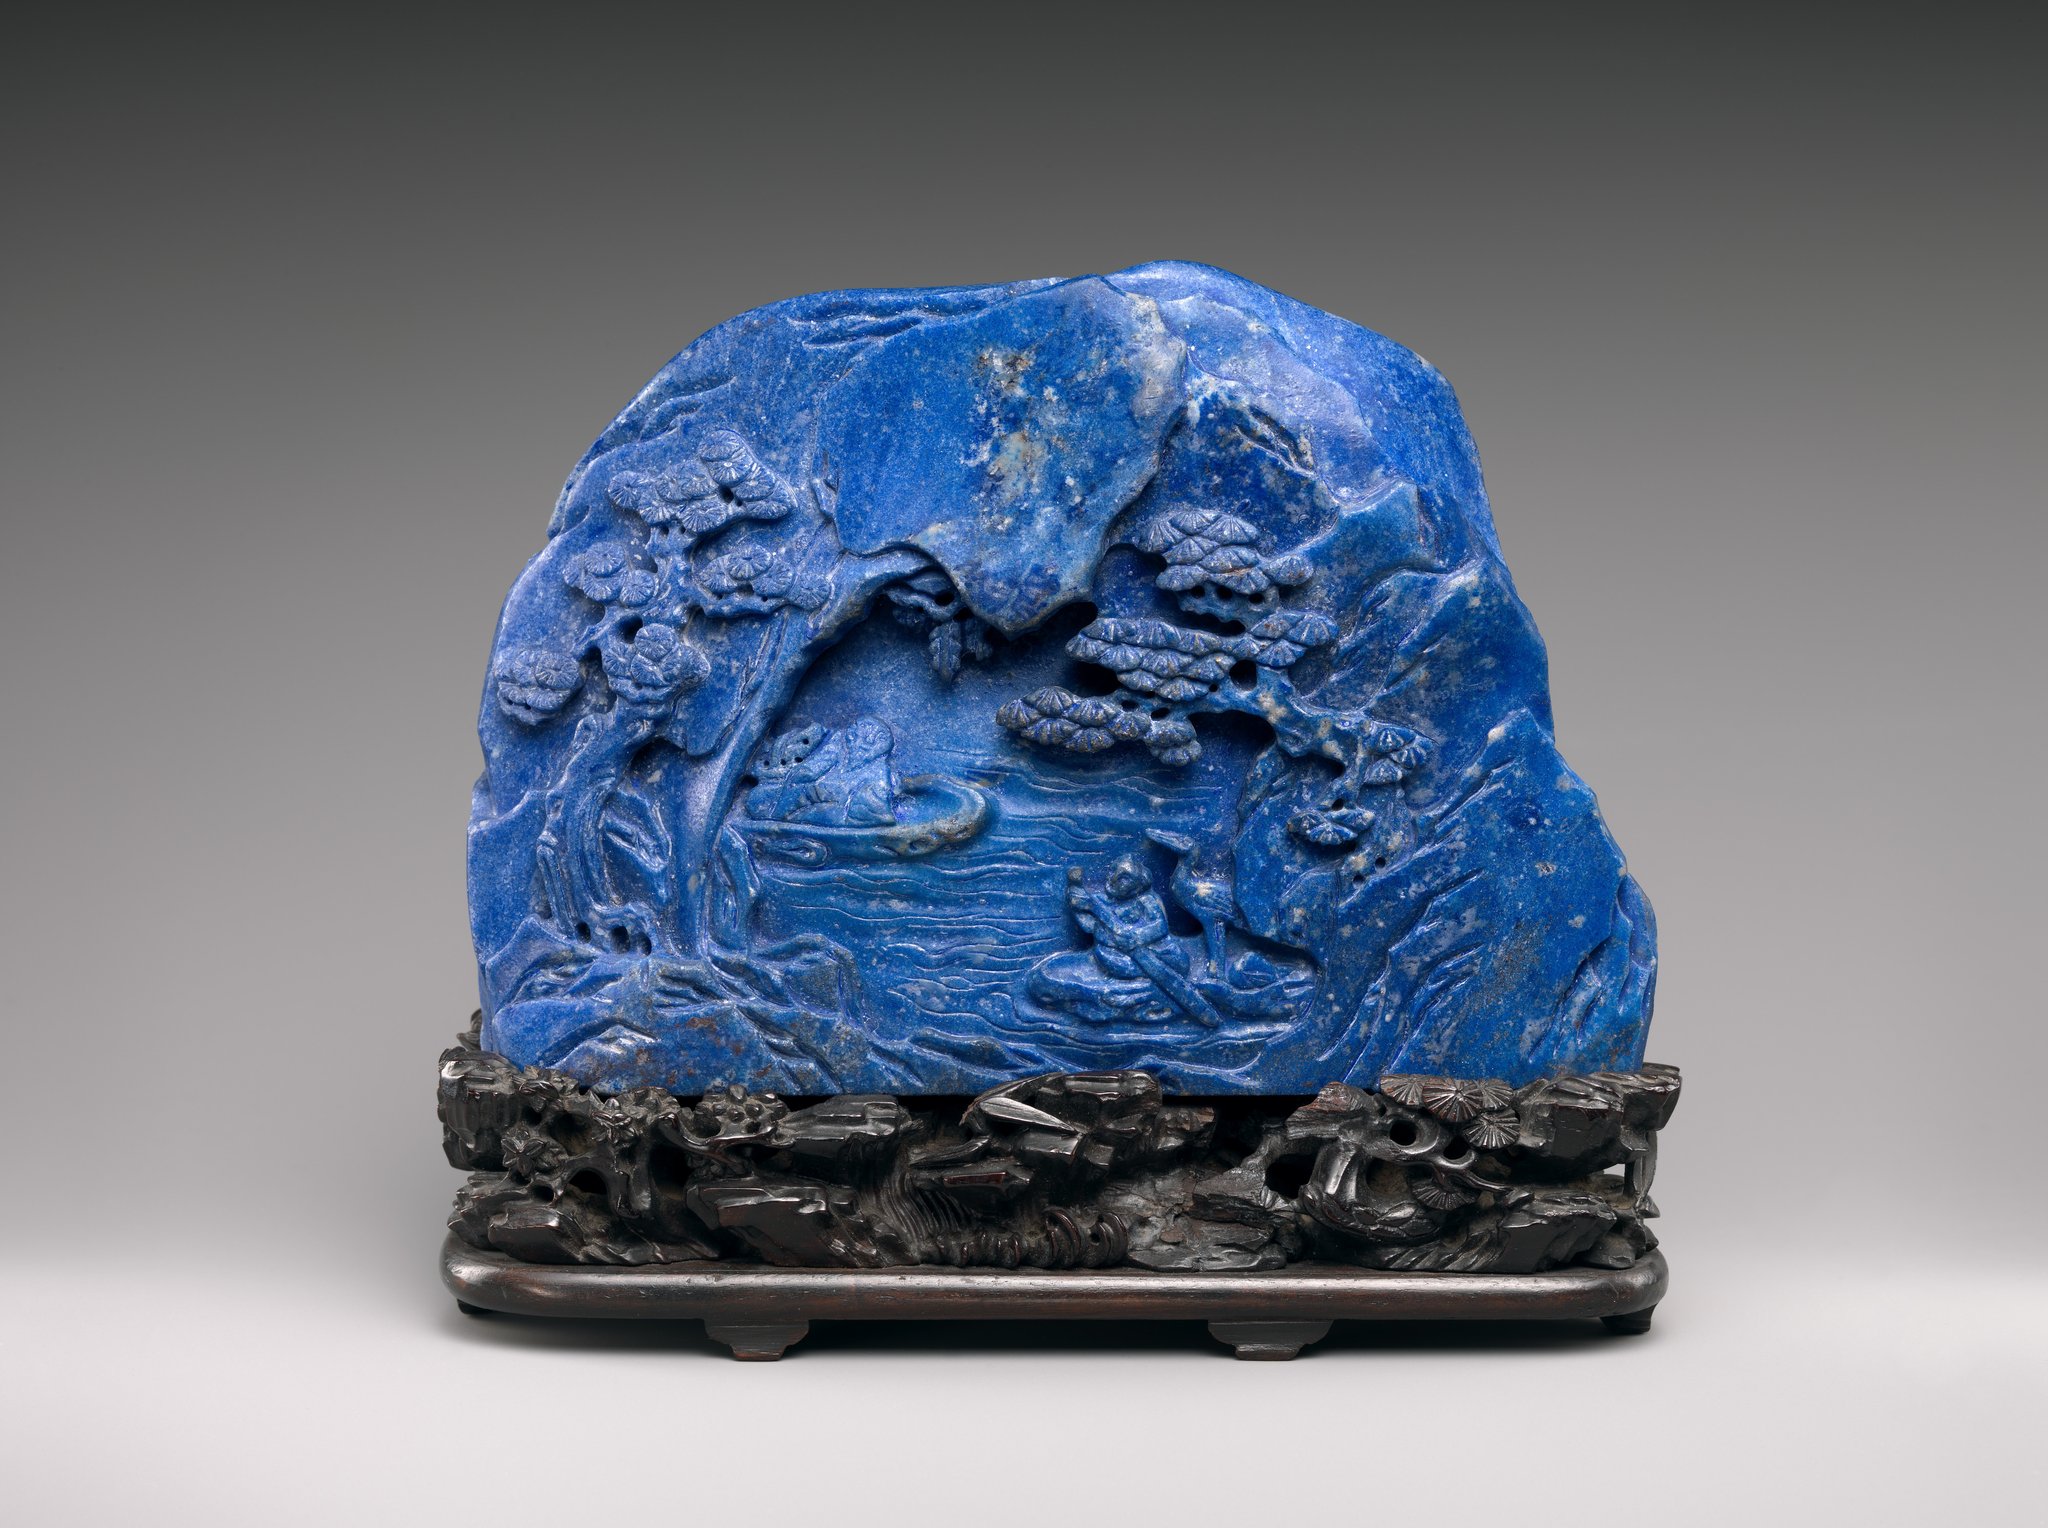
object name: relief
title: Mountain with landscape scene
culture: chinese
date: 1701-1800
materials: lapis lazuli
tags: landscapes,boats